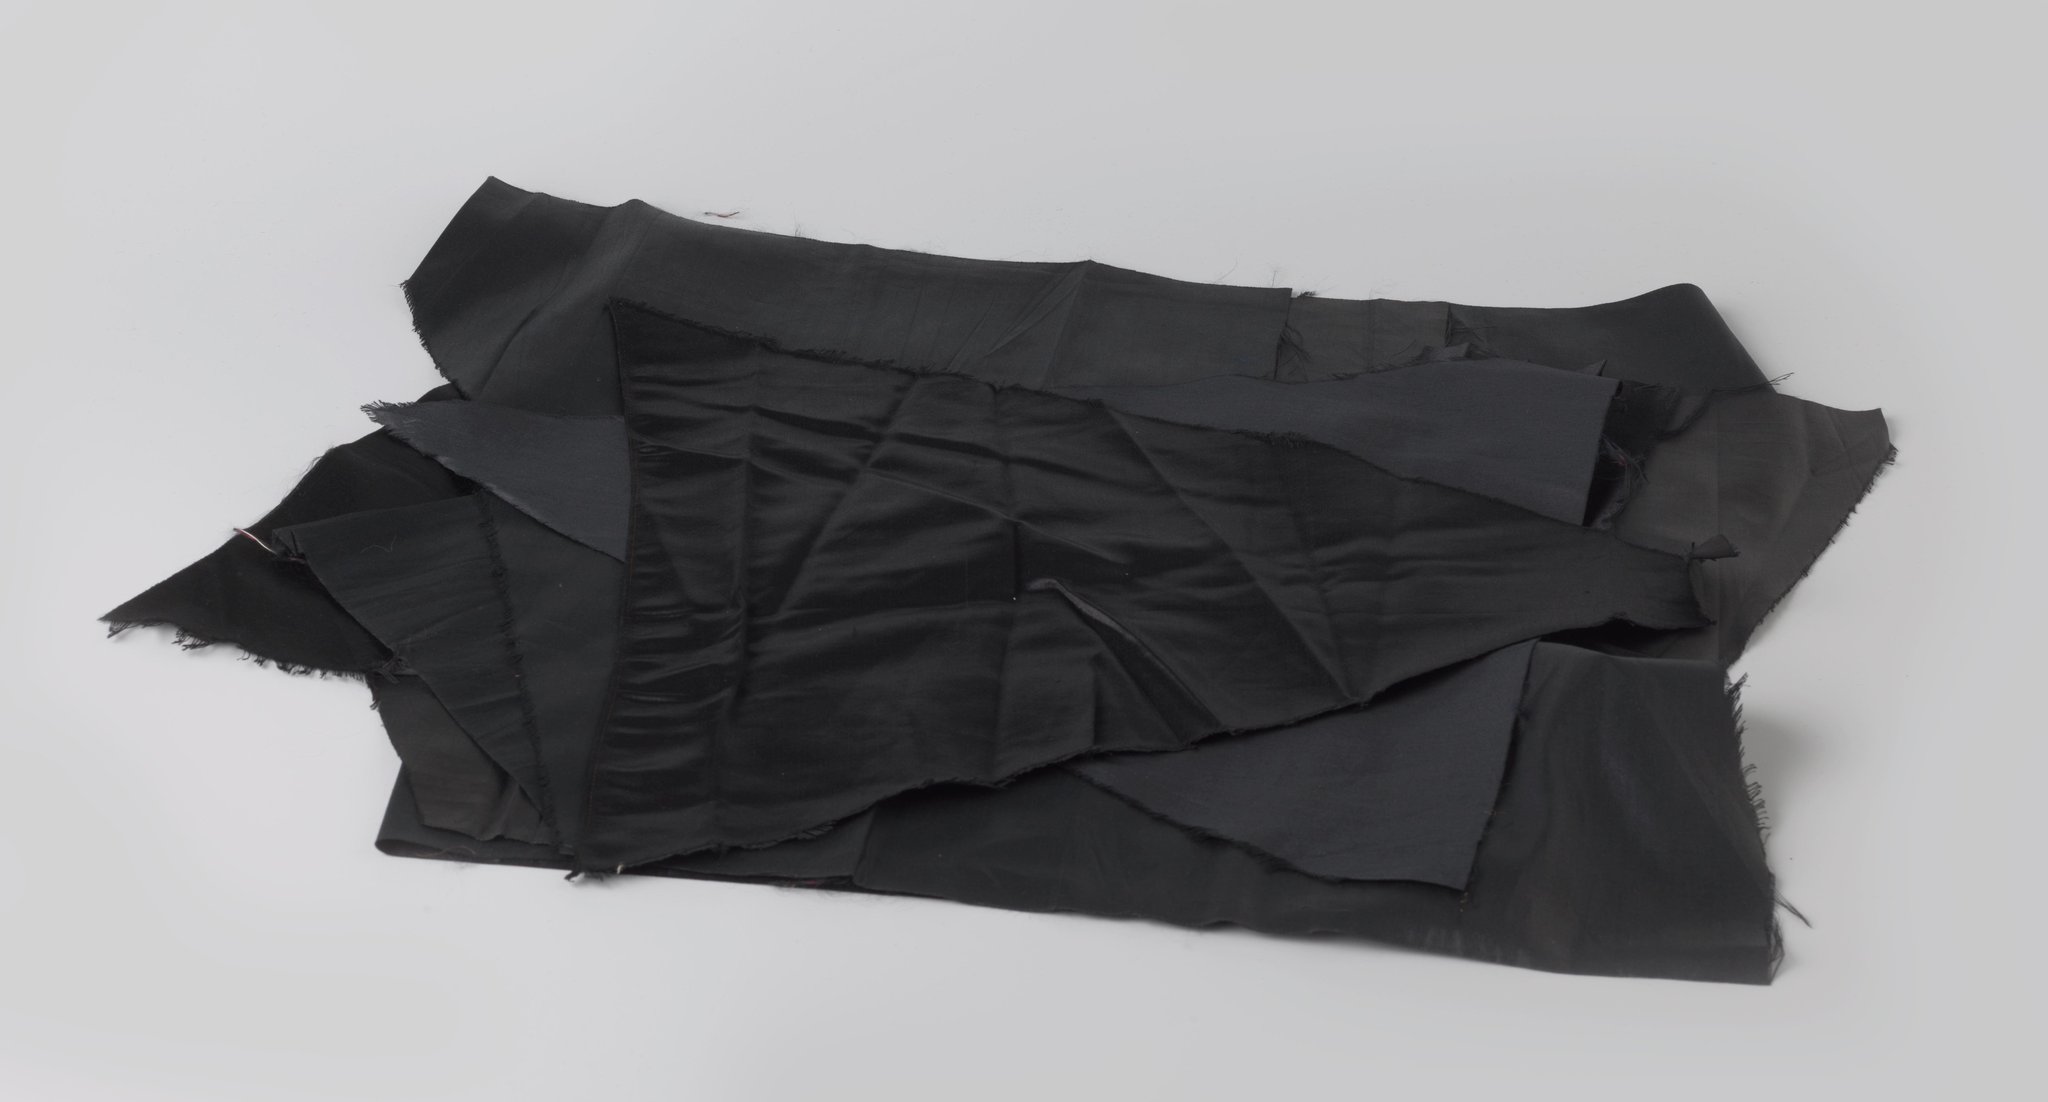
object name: fragment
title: Fragment van effen zwart zijden satijn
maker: Anonymous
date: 1930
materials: silk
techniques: weave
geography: switzerland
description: Metrages parapluiesatijn. Zuiver zijde. Zwart satijn.